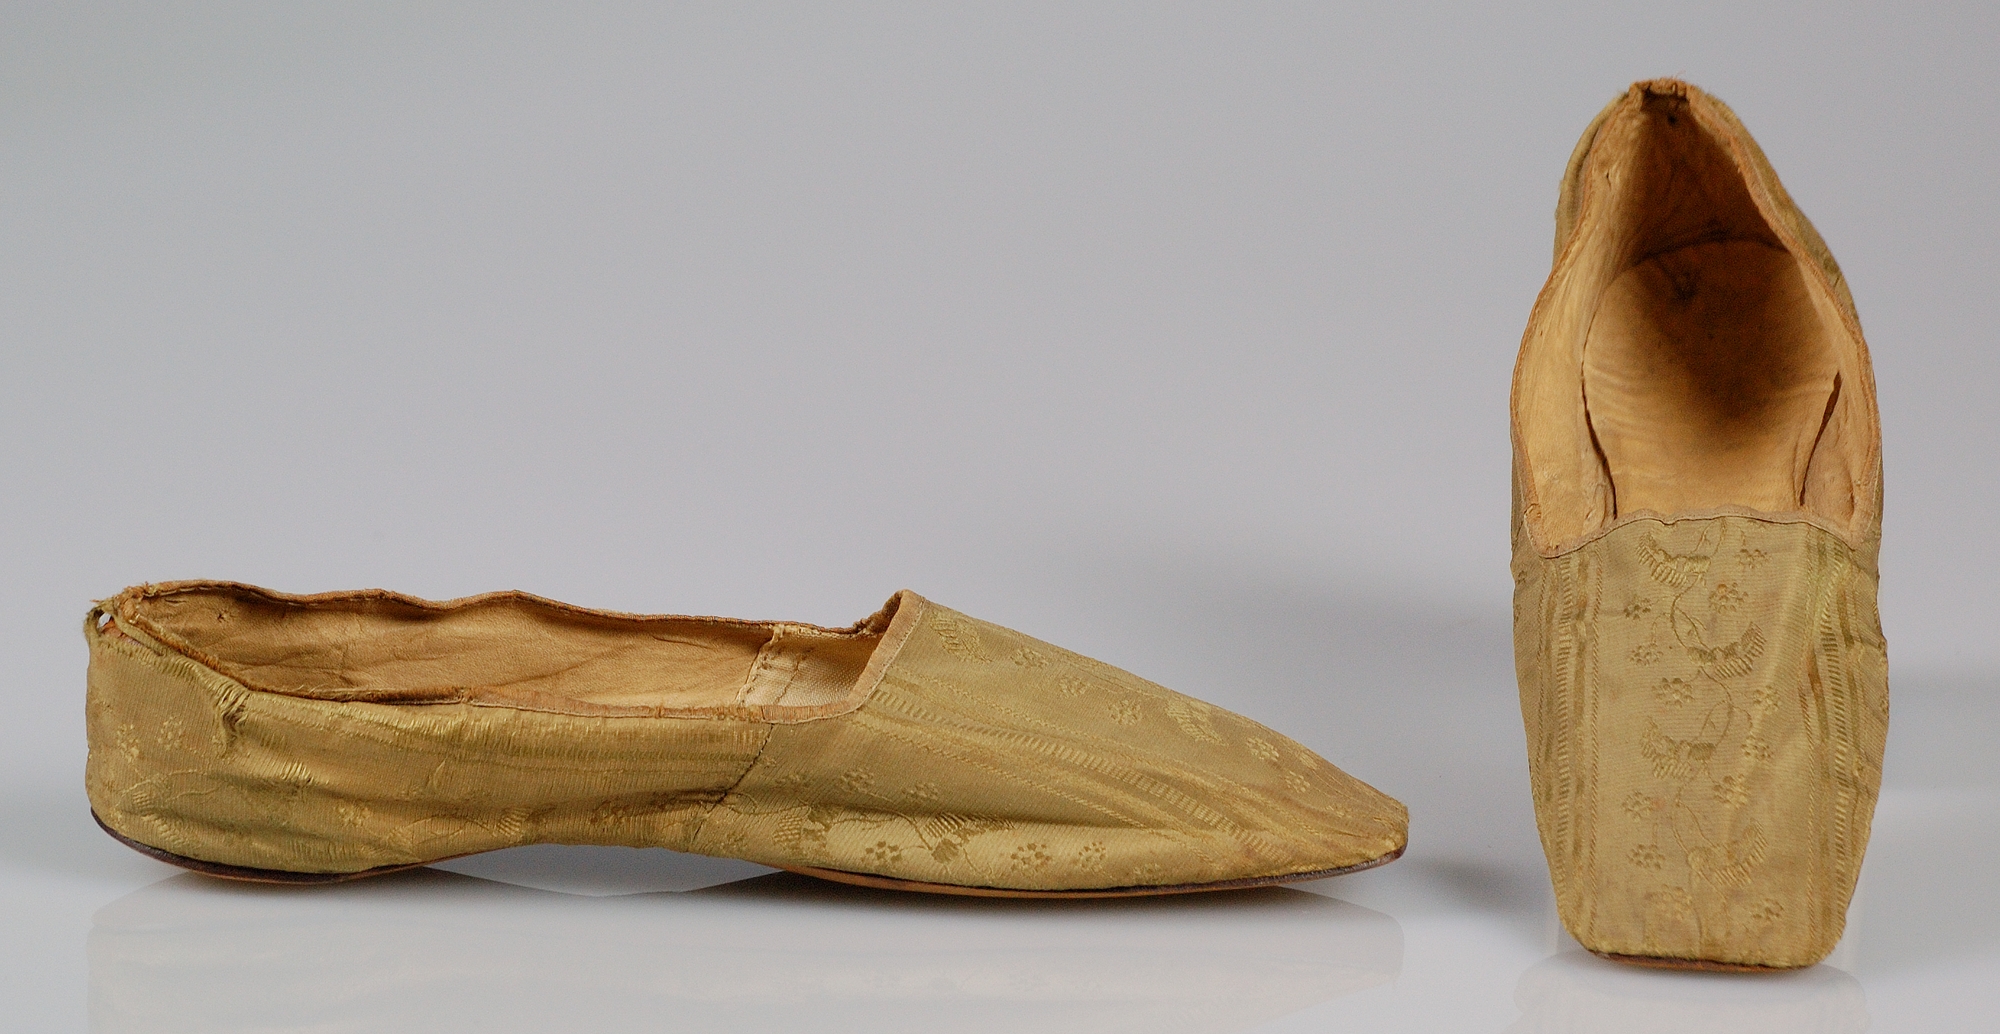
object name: slipper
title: Slippers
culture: american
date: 1850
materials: silk